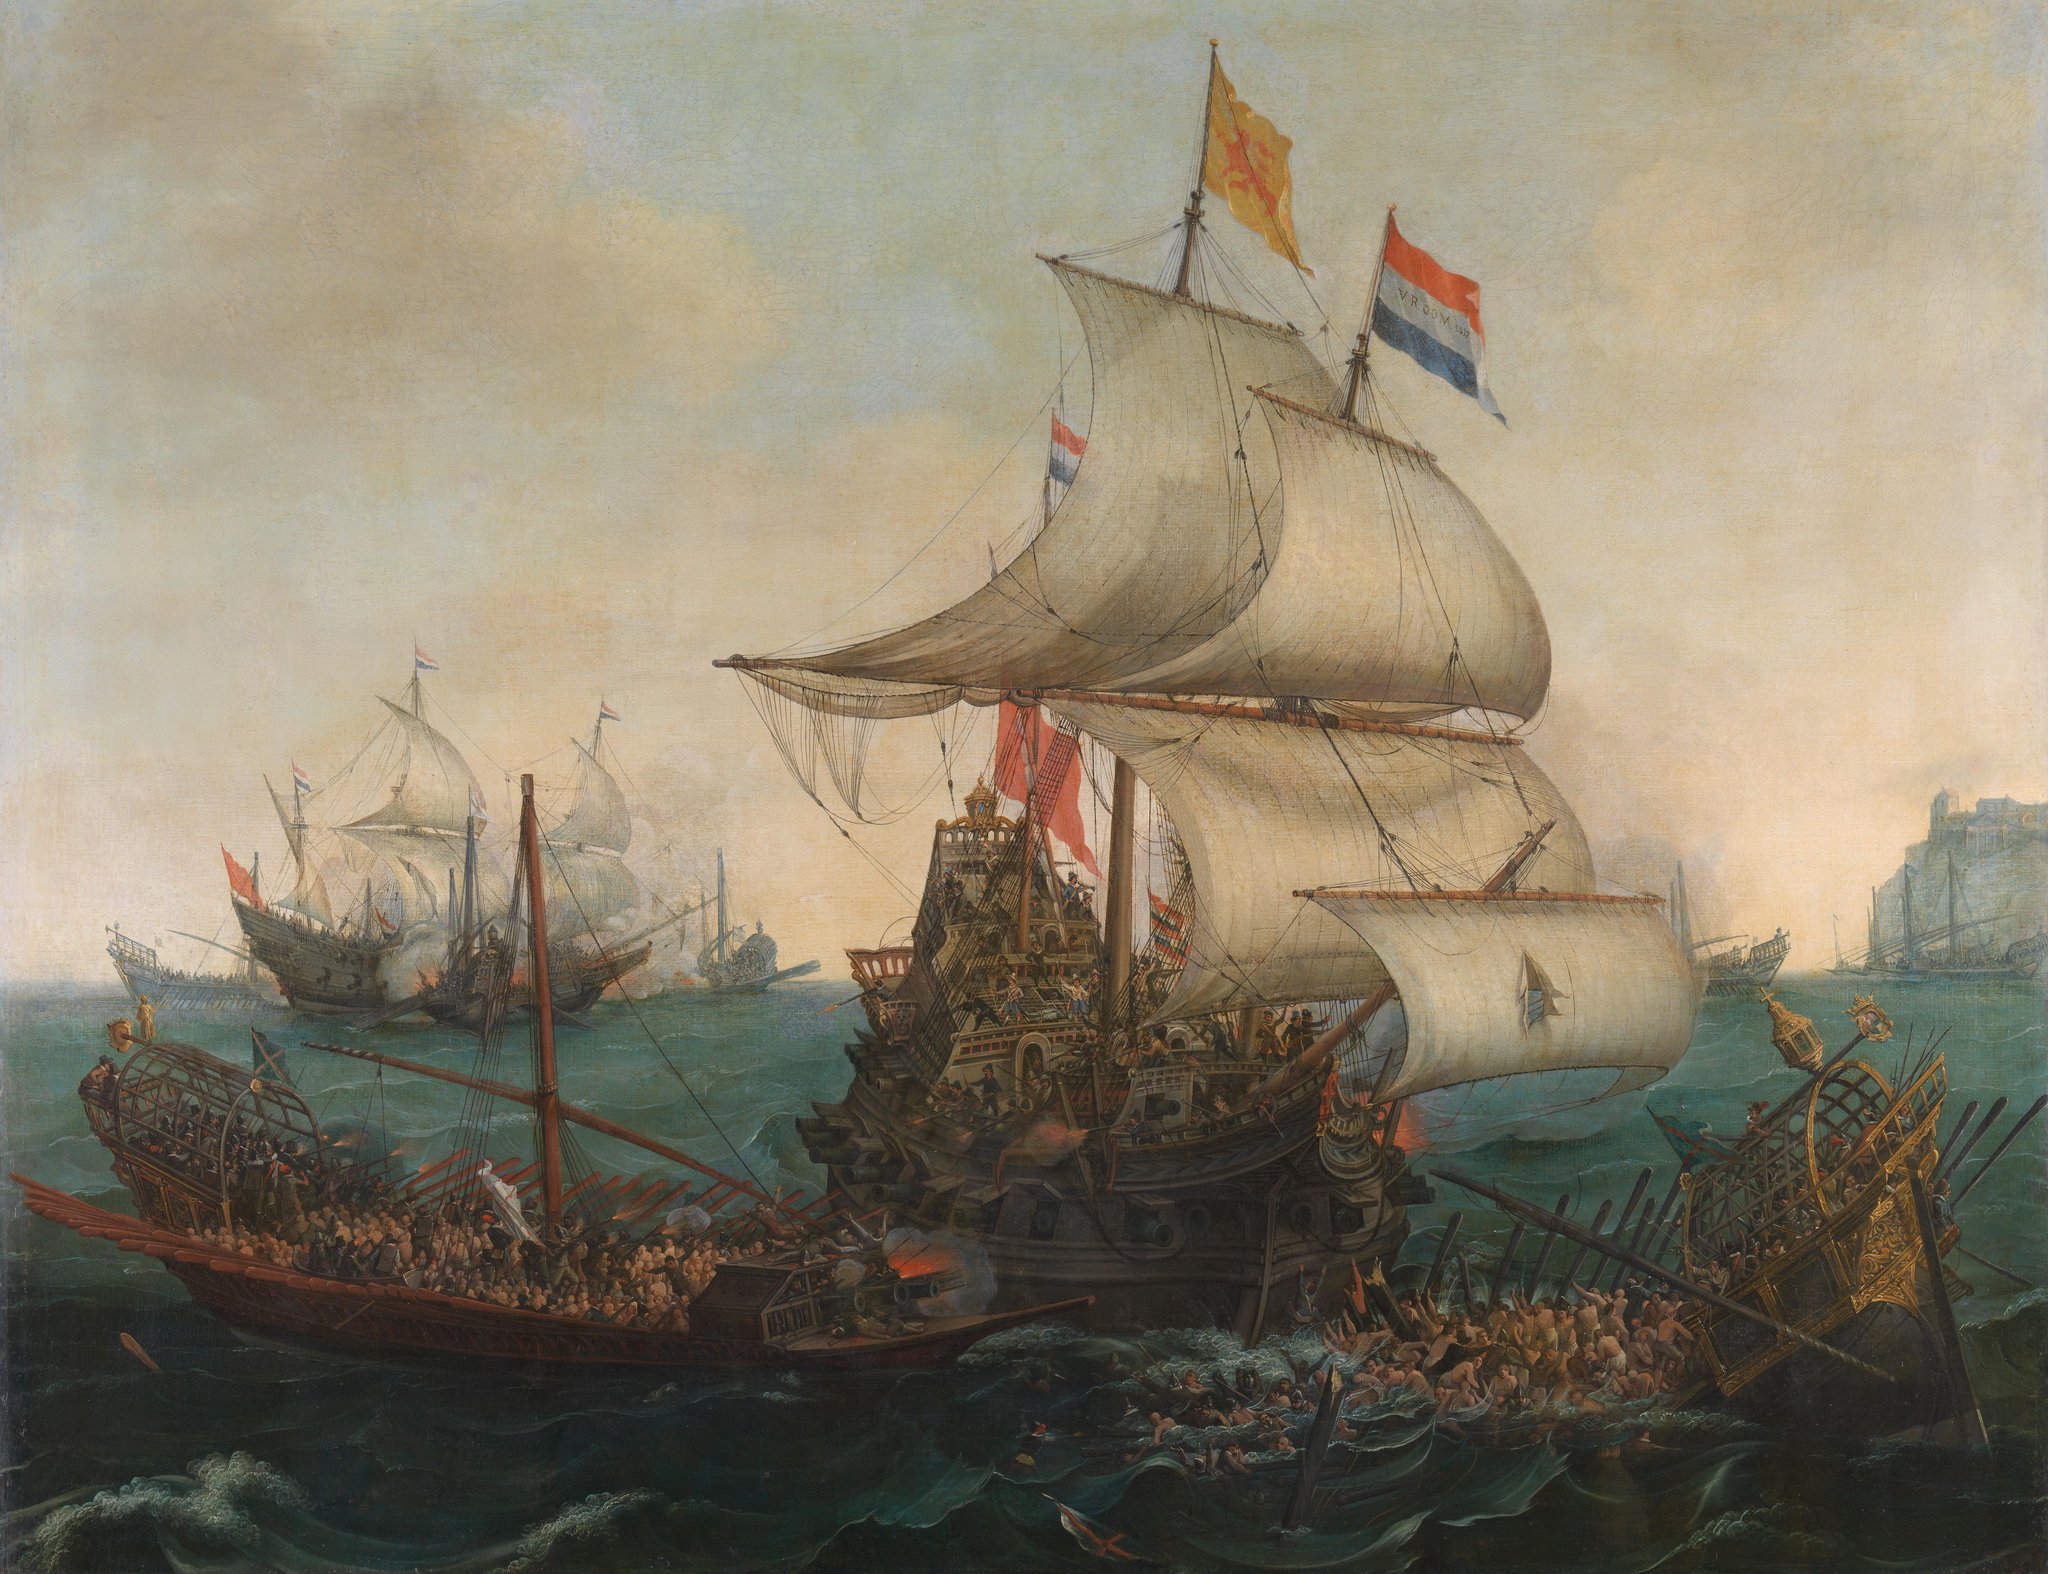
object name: painting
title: Dutch Ships Ramming Spanish Galleys off the English Coast, 3 October 1602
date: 1617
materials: canvas, oil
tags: sailing-ship, sailing-boat, battle (+ naval force), trireme, galley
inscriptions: signature and date, top centre on the flag: ‘VROOM 1617’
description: Terror emanates from the bald-shaven and half-naked galley slaves. While the soldiers aboard still have a chance to escape, the enslaved crew remains chained to the rowing benches, condemned to face death by drowning. The Dutch revolt against Spain unfolded primarily at sea, where the Spanish galleys proved powerless against the robust Dutch three-masters that simply rammed into them.